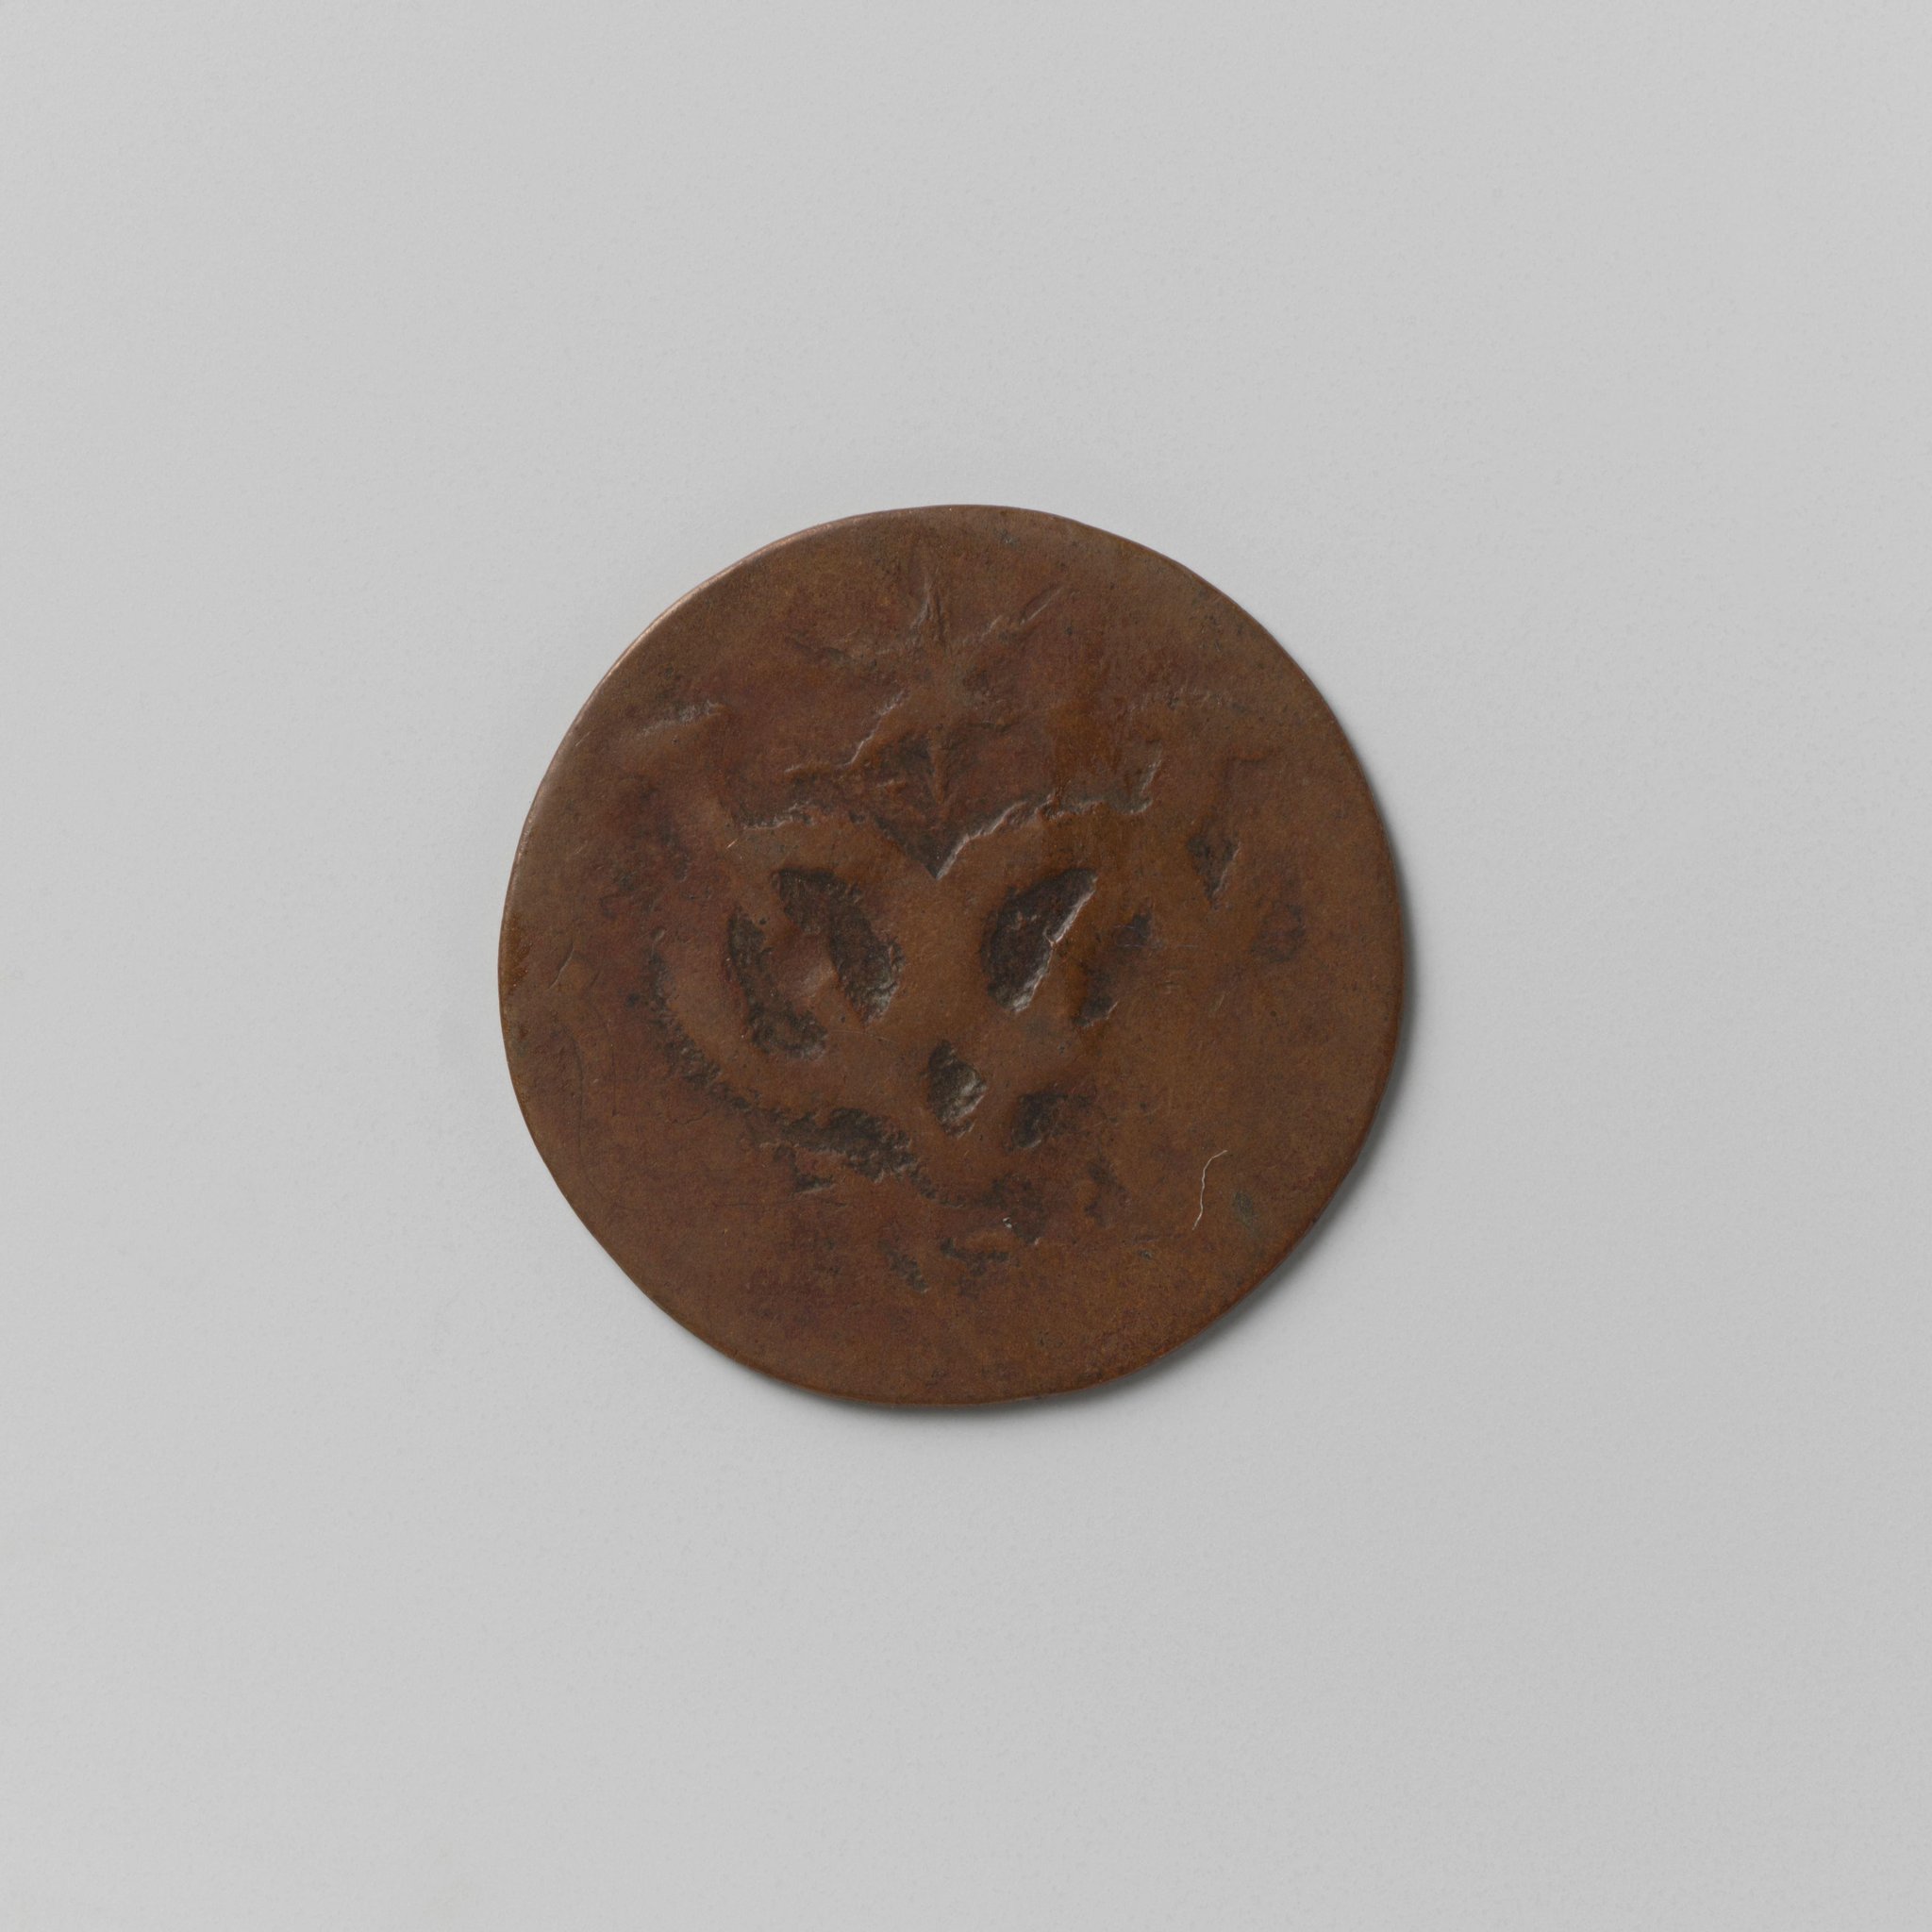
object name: coin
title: Nabootsing van een duit van de VOC uit West-Friesland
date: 1780-1830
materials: copper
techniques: striking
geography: banjarmasin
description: Koperen munt. Nabootsing van duit van de VOC uit West-Friesland. Voorzijde: gekroond wapenschild van West-Friesland. Keerzijde: monogram van de VOC, waarboven ster en waaronder fictief jaartal.